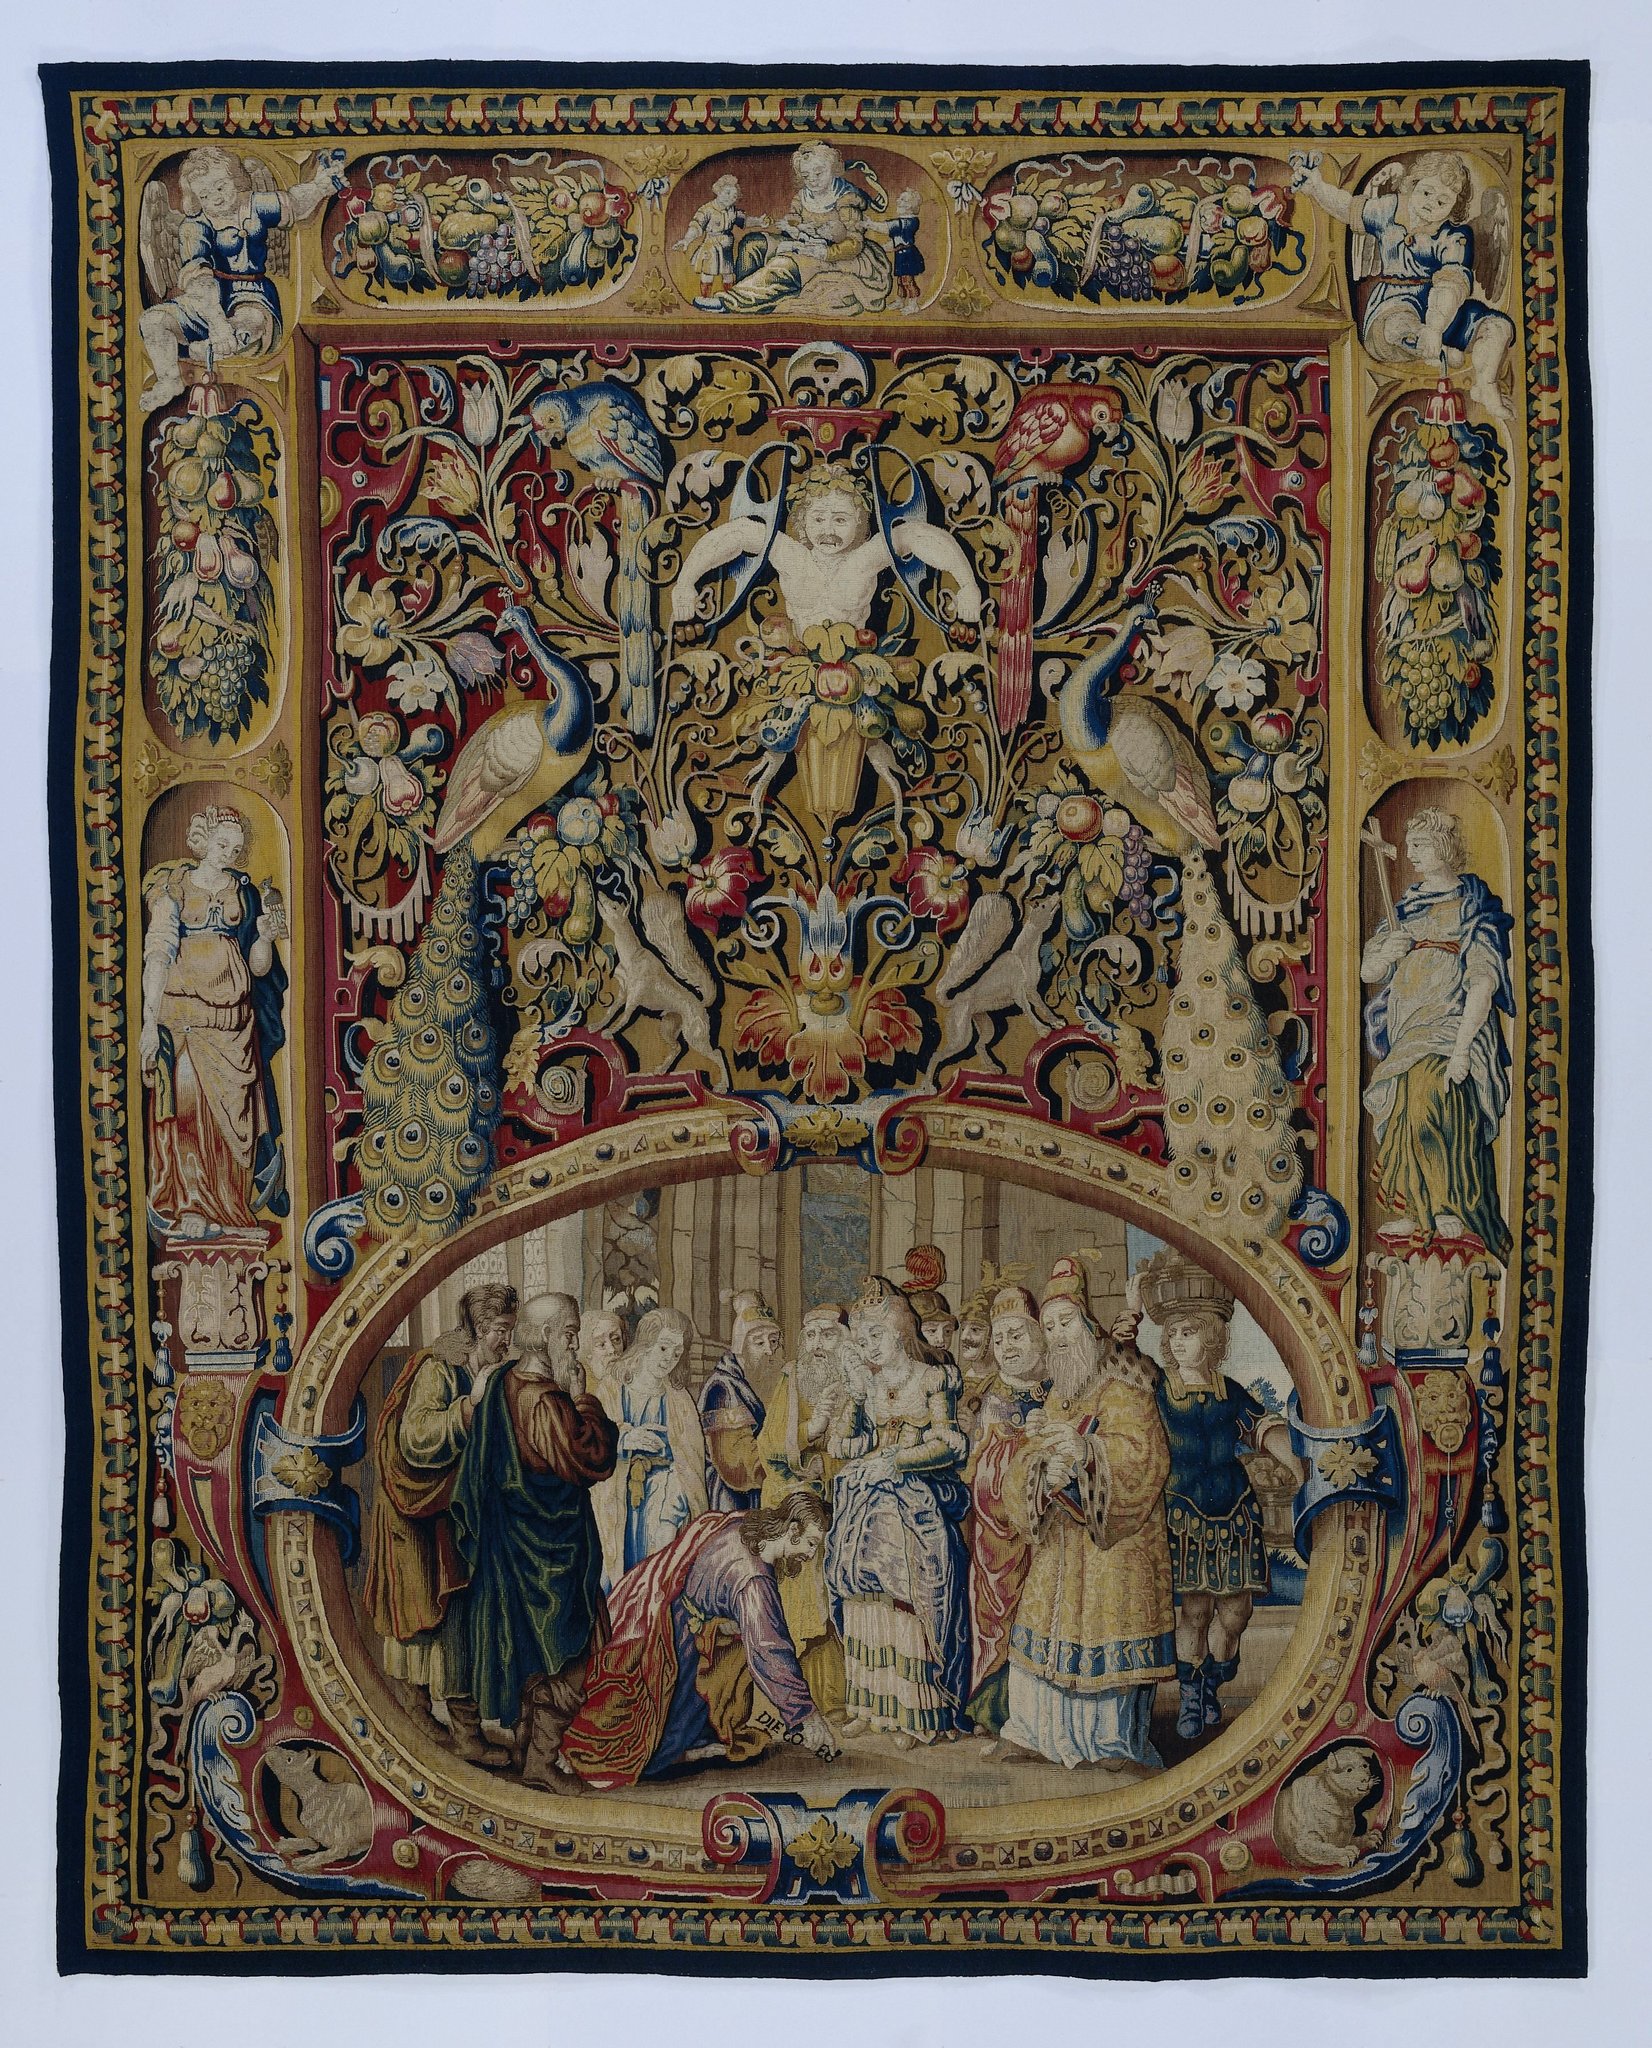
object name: tapestry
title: Christus en de overspelige vrouw, in een cartouche en een groteskendecor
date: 1610-1625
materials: silk, wool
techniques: tapestry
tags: ornament ~ grotesque, christ points to or writes on the ground, pharisees bring a woman accused of adultery before christ (john 8:2-11), ornamental birds: peacock, ornament ~ festoon, garland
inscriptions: inscription: ‘DIE SO[ND]ER’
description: Tapestry with Christ and the woman taken in adultery. Delft (?), workshop of Frans Spierings or Aert Spierings (?), c. 1600, design attributed to Adam van Noort.